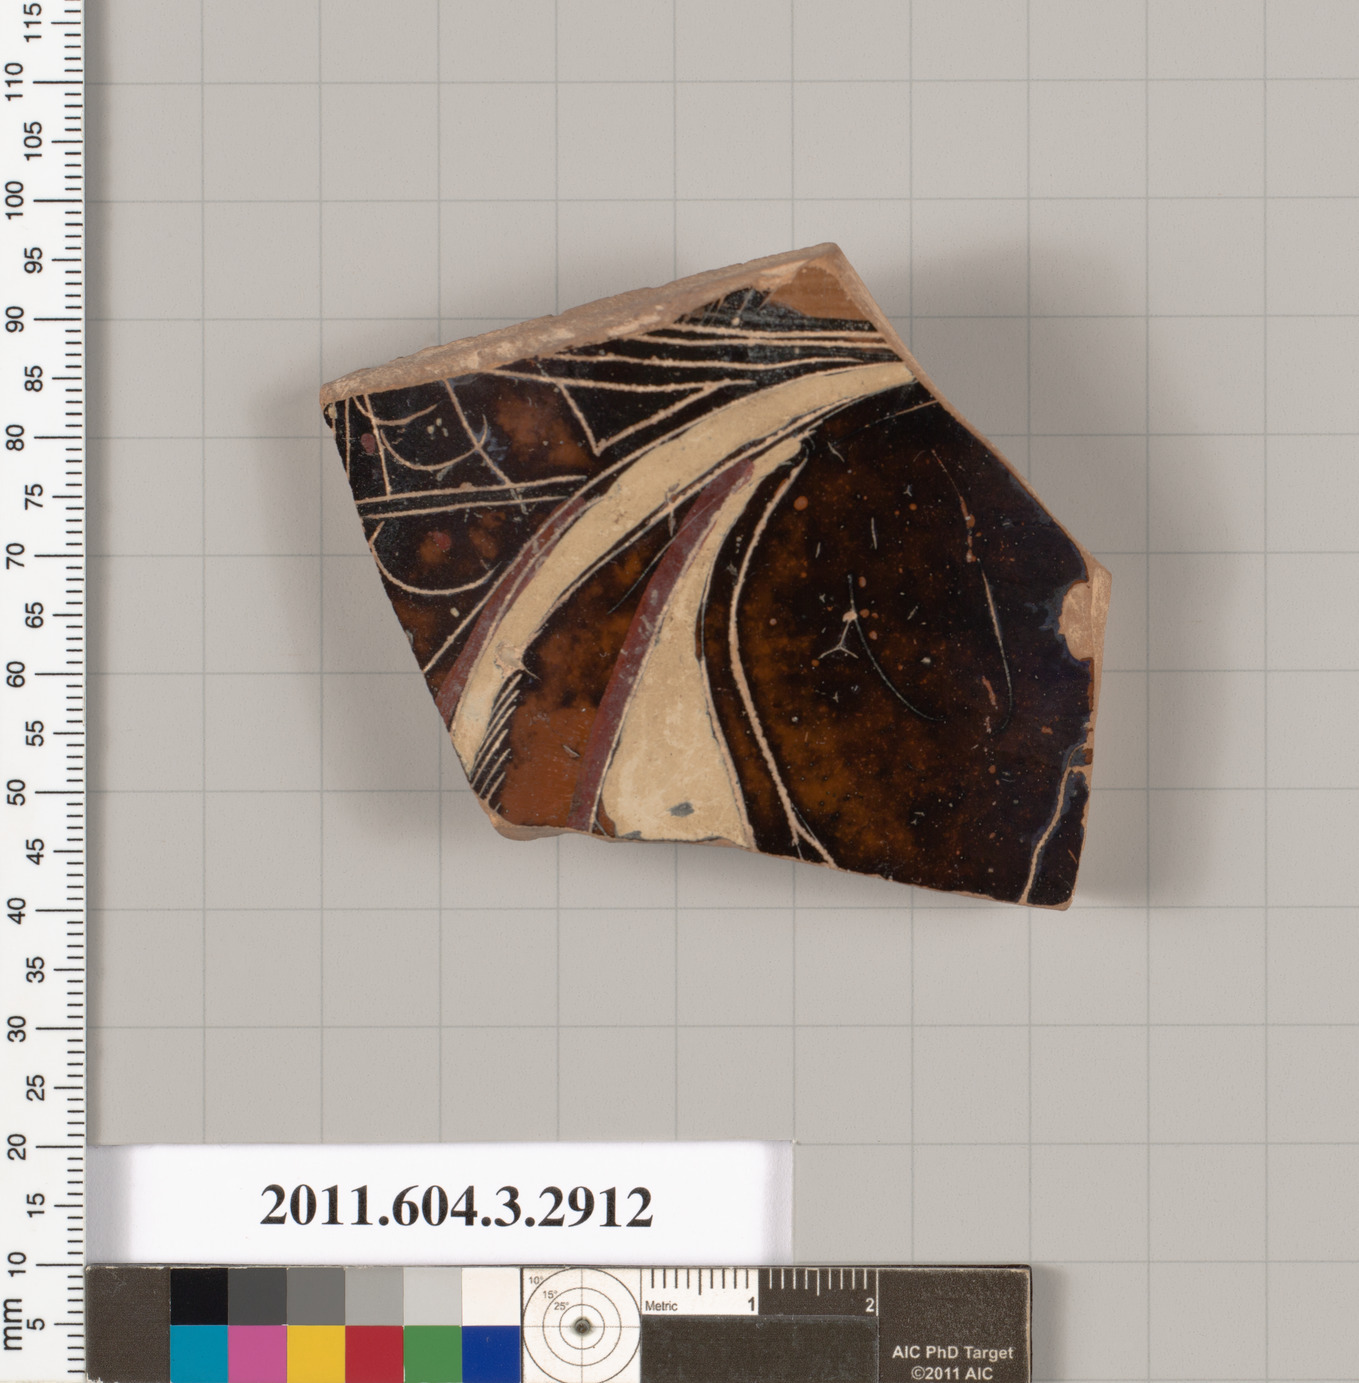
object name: amphora fragment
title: Terracotta fragment of an amphora (jar)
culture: greek, attic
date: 575-551 BCE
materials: terracotta